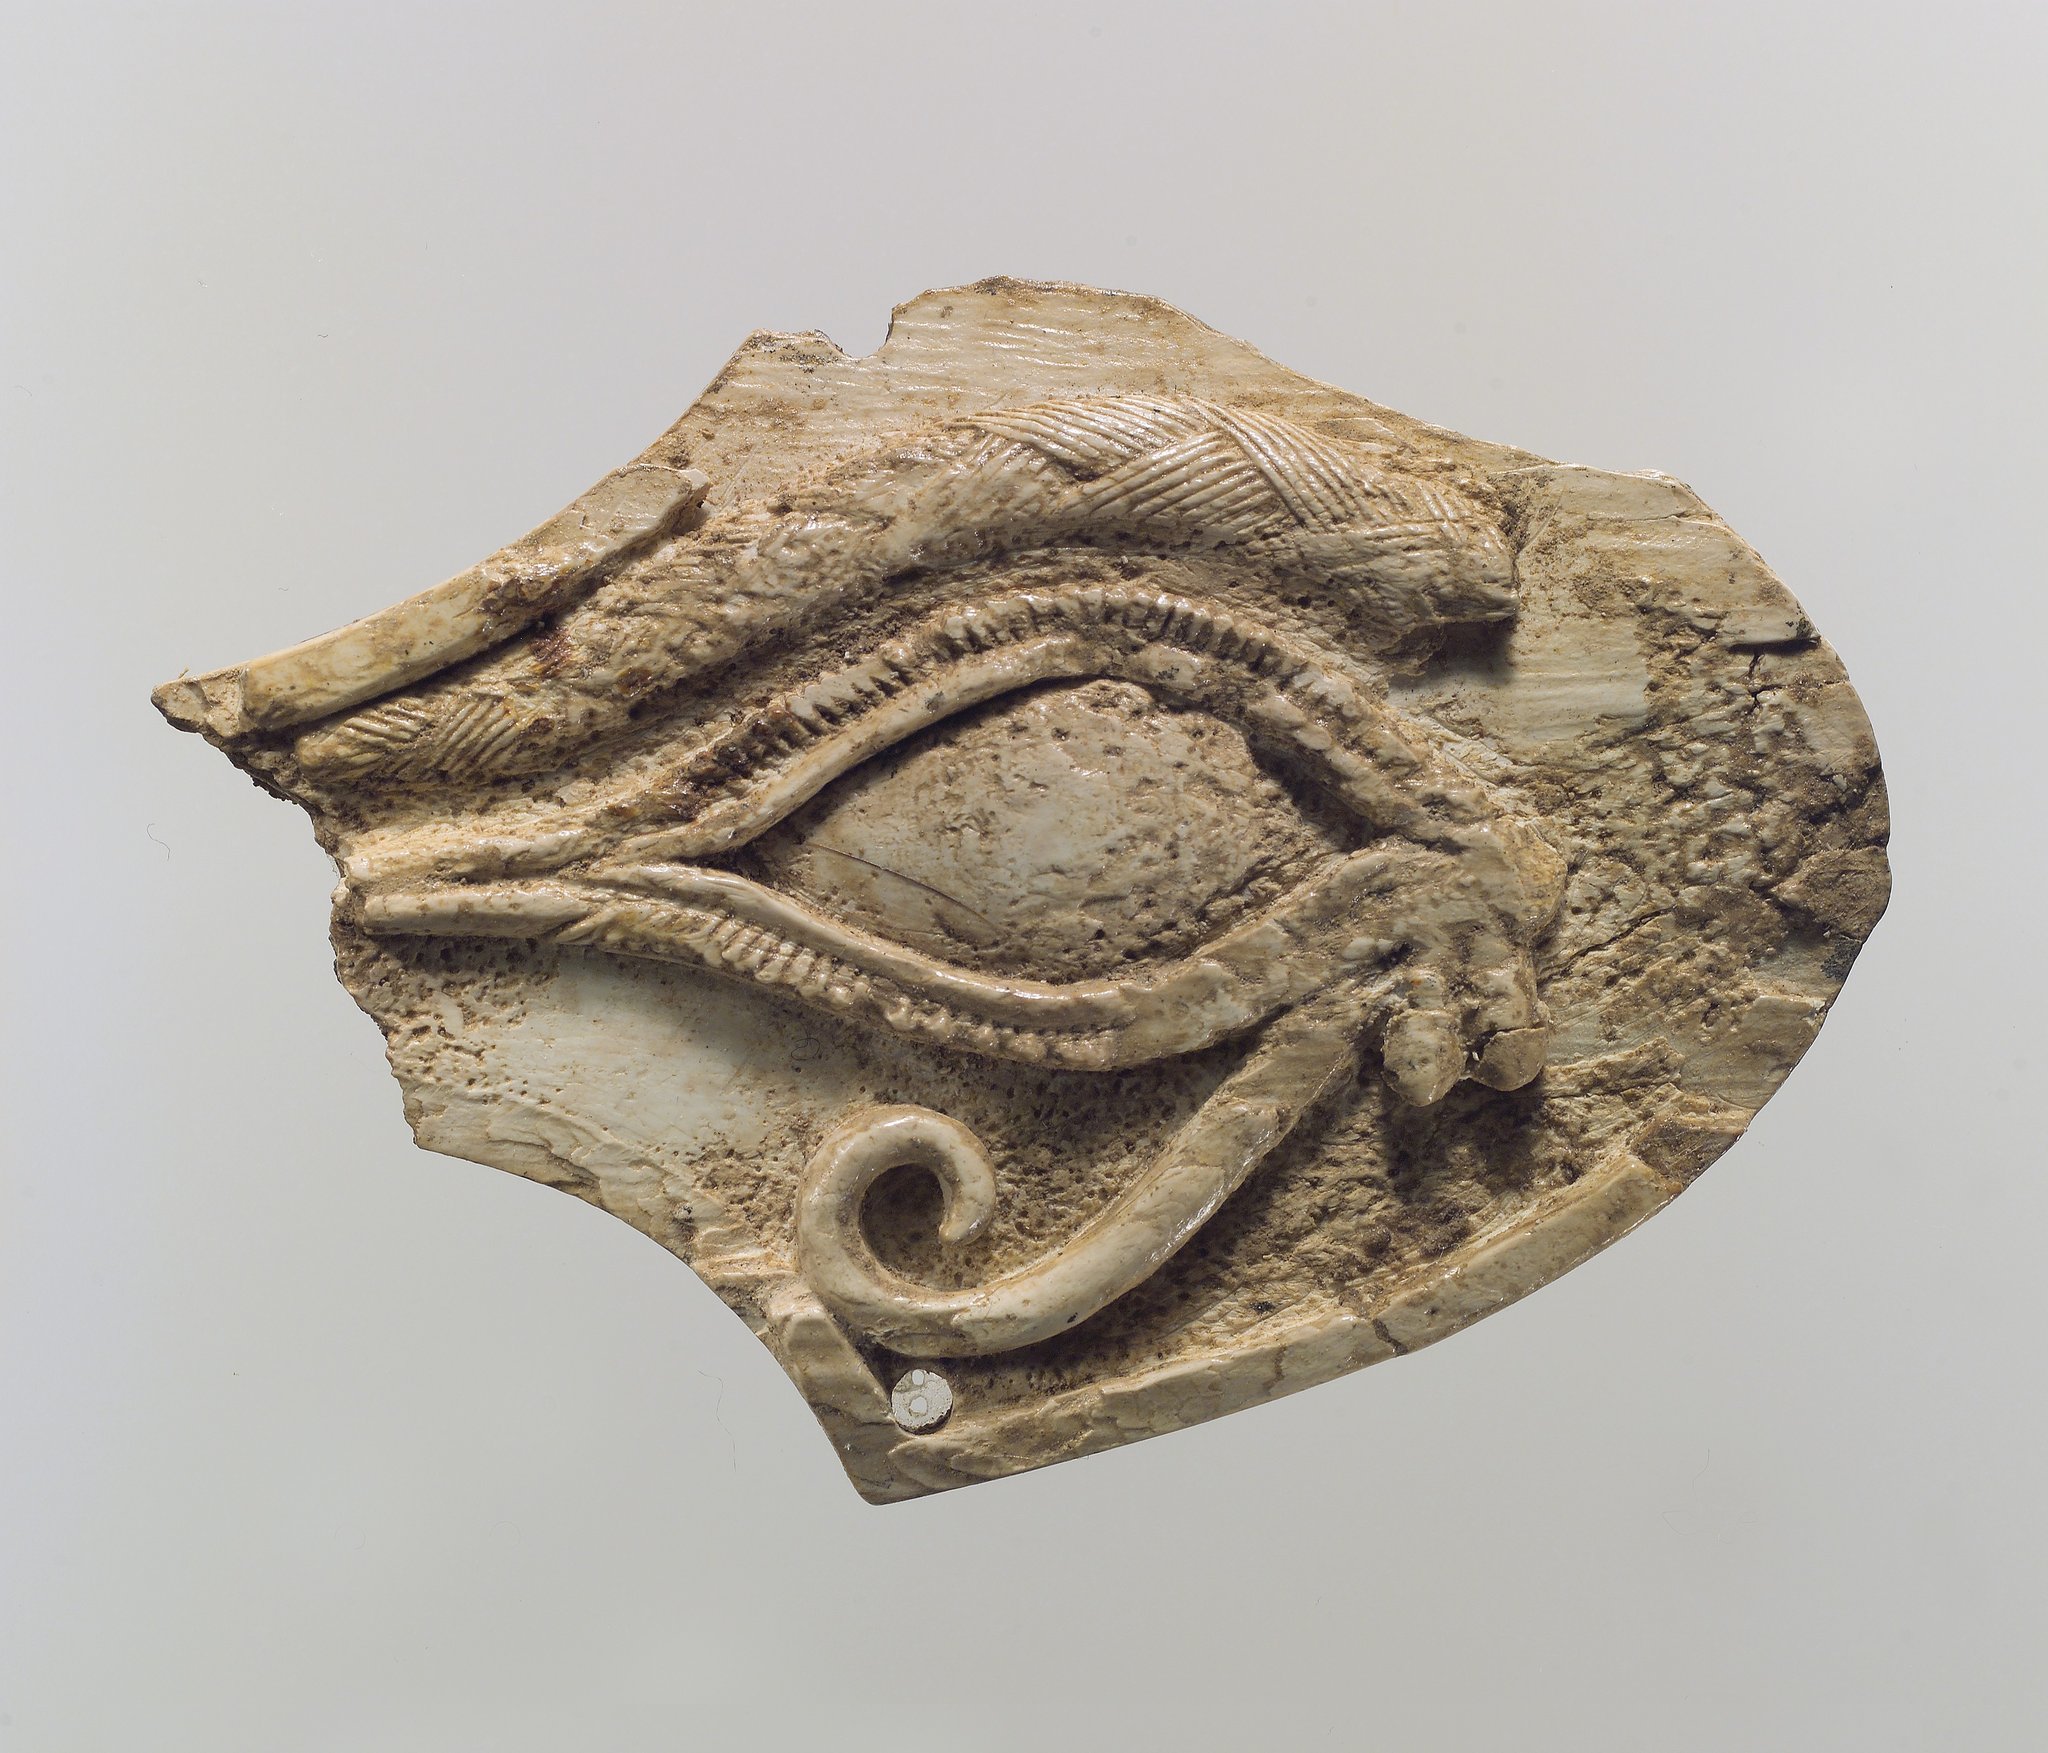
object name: horse blinker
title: Horse blinker carved in relief with a wedjat eye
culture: assyrian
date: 800-701 BCE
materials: ivory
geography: mesopotamia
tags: eyes